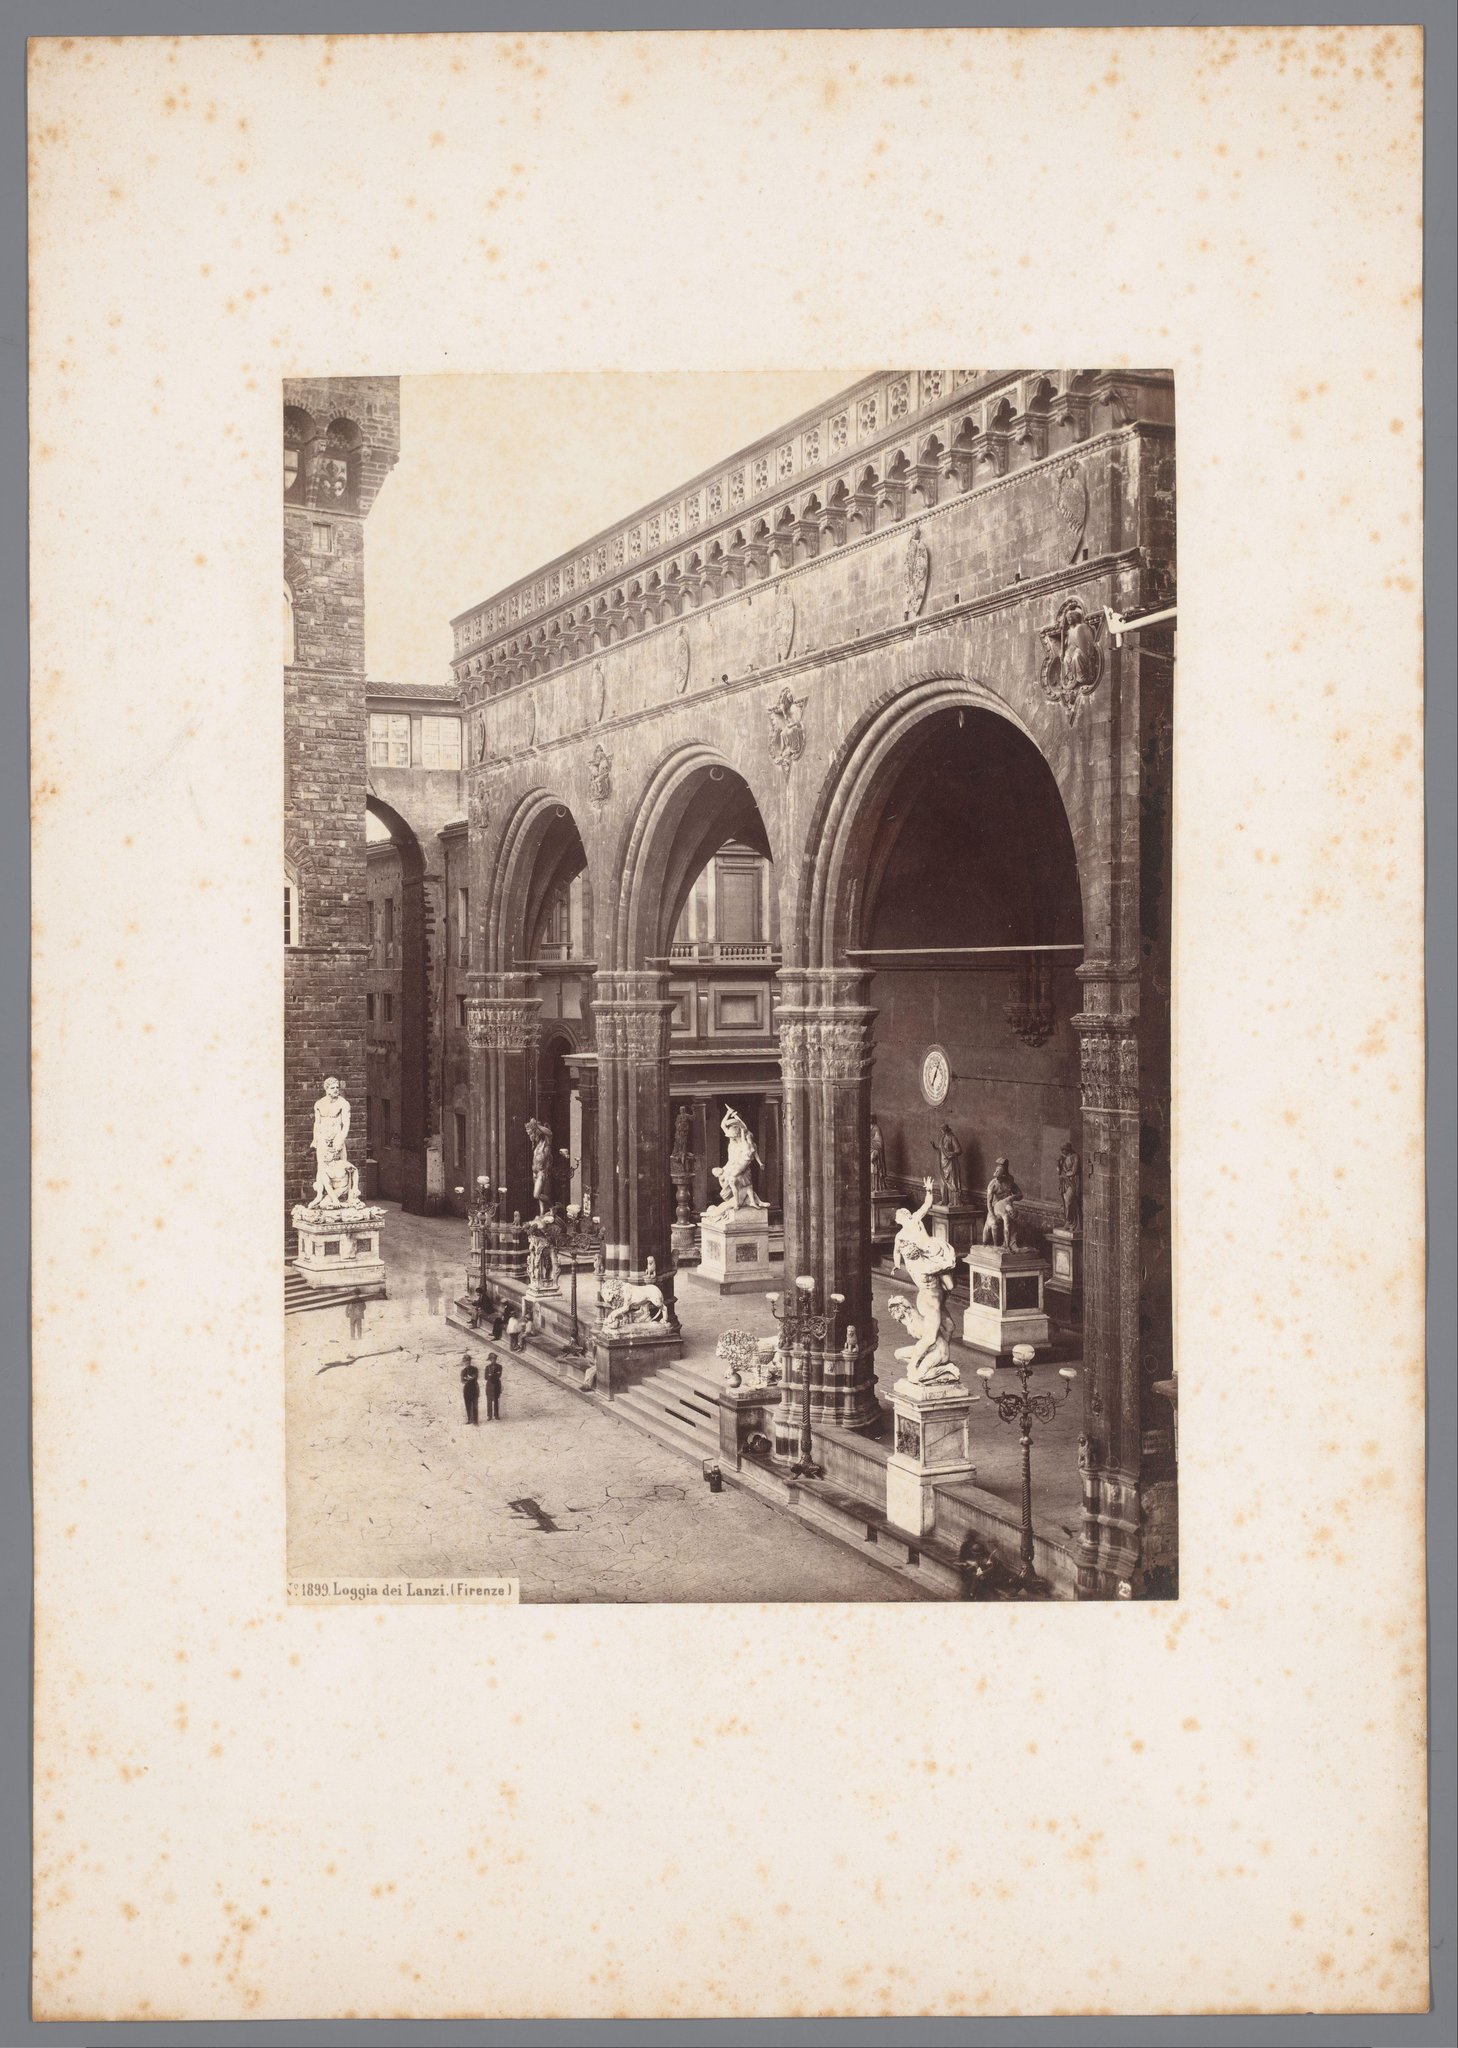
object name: photograph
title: (Firenze)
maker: giorgio sommer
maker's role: fotograaf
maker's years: 1834-1914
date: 1863-1914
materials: cardboard, paper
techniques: albumen print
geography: florence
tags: gallery of sculptures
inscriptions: number: ‘26’, inscription: ‘Sommer (t)’, number: ‘No. 1899.’